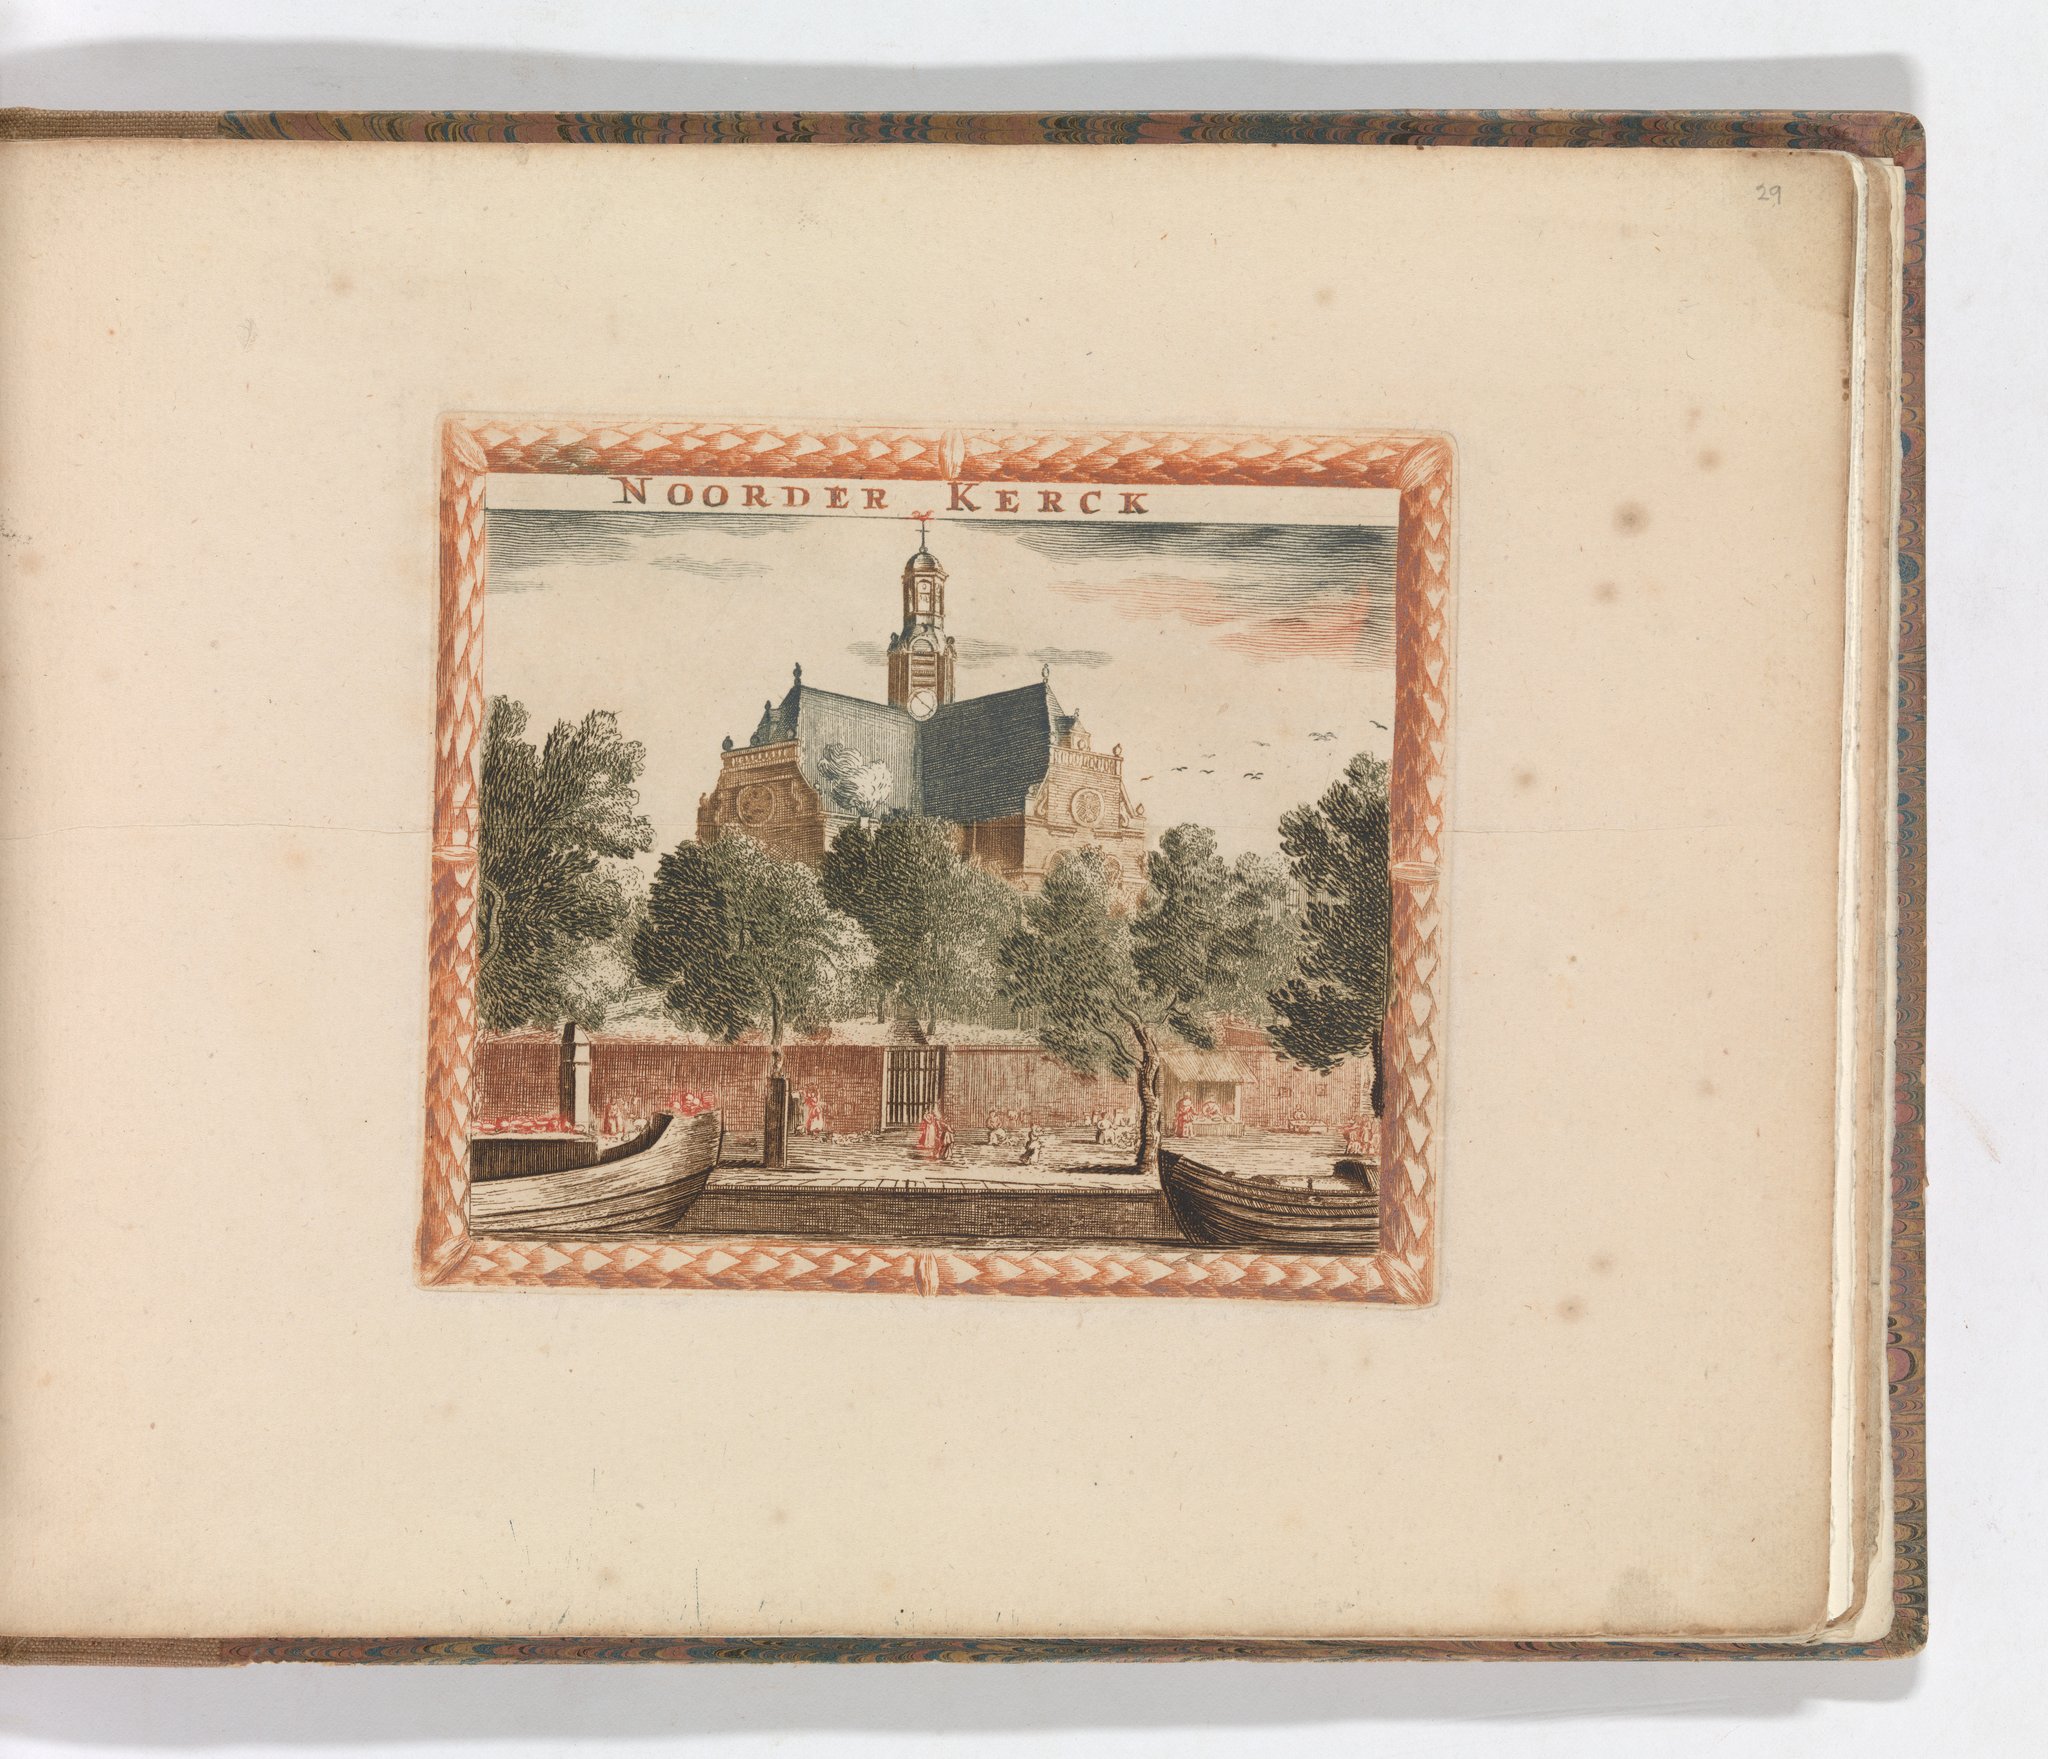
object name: book print ornament architecture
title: 'Noorder Kerck', in: Tooneel Der Voornaamste Nederlands Huizen, En Lust Hoven, Naar T Leven Afgebeeld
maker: carel allard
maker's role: publisher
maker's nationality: dutch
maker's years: 1648-1709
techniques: engraving, lithography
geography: amsterdam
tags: churches,trees,boats